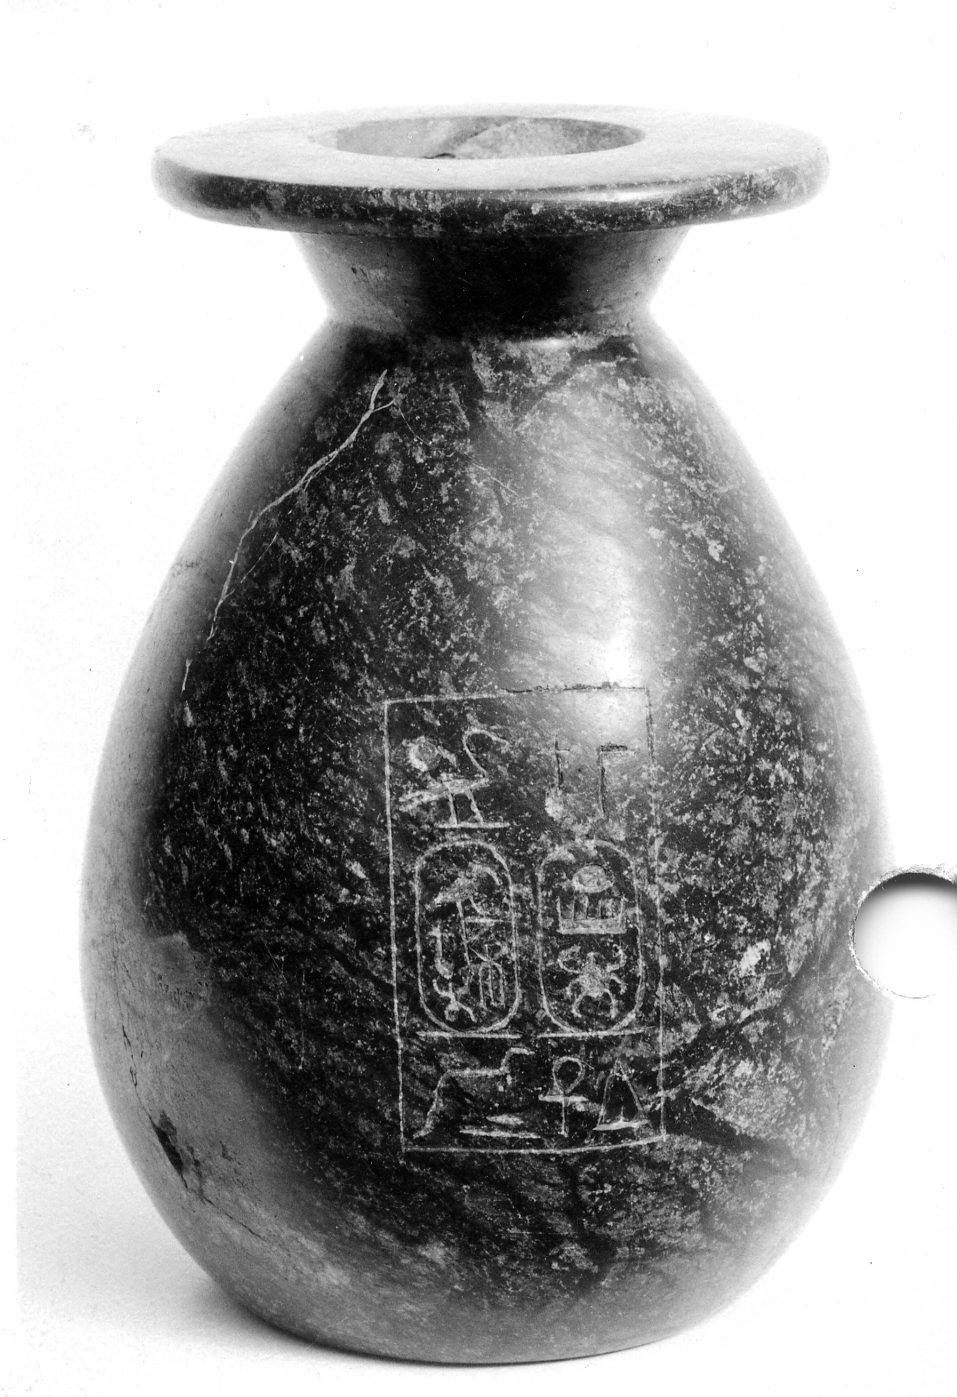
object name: jar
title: Storage jar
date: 1479-1425 BCE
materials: stone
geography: egypt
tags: hieroglyphs